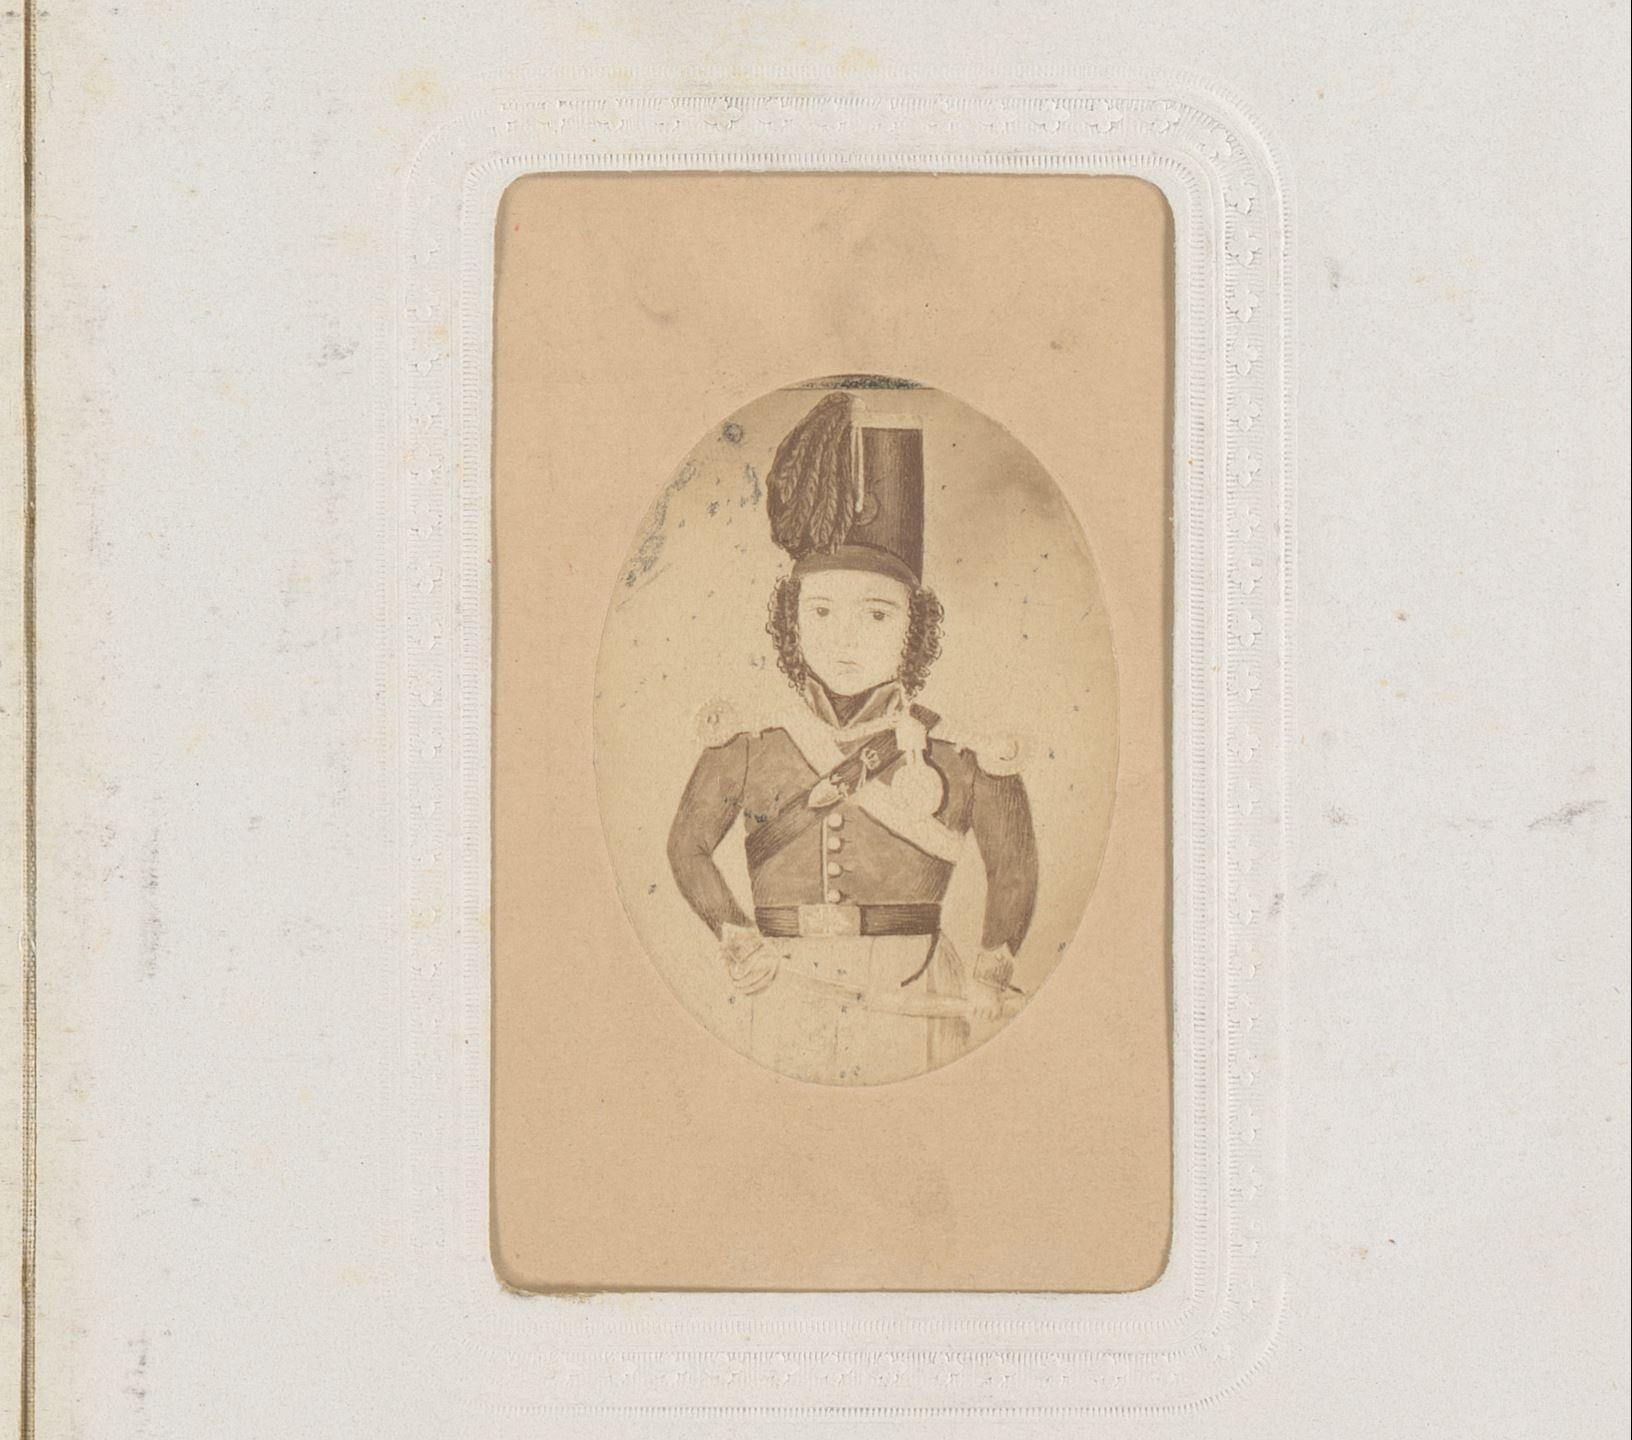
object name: photograph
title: Fotoreproductie van een portret van een jongen in uniform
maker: Anonymous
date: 1860-1890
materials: cardboard, photographic support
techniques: albumen print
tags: boy (child between toddler and youth), (military) uniforms